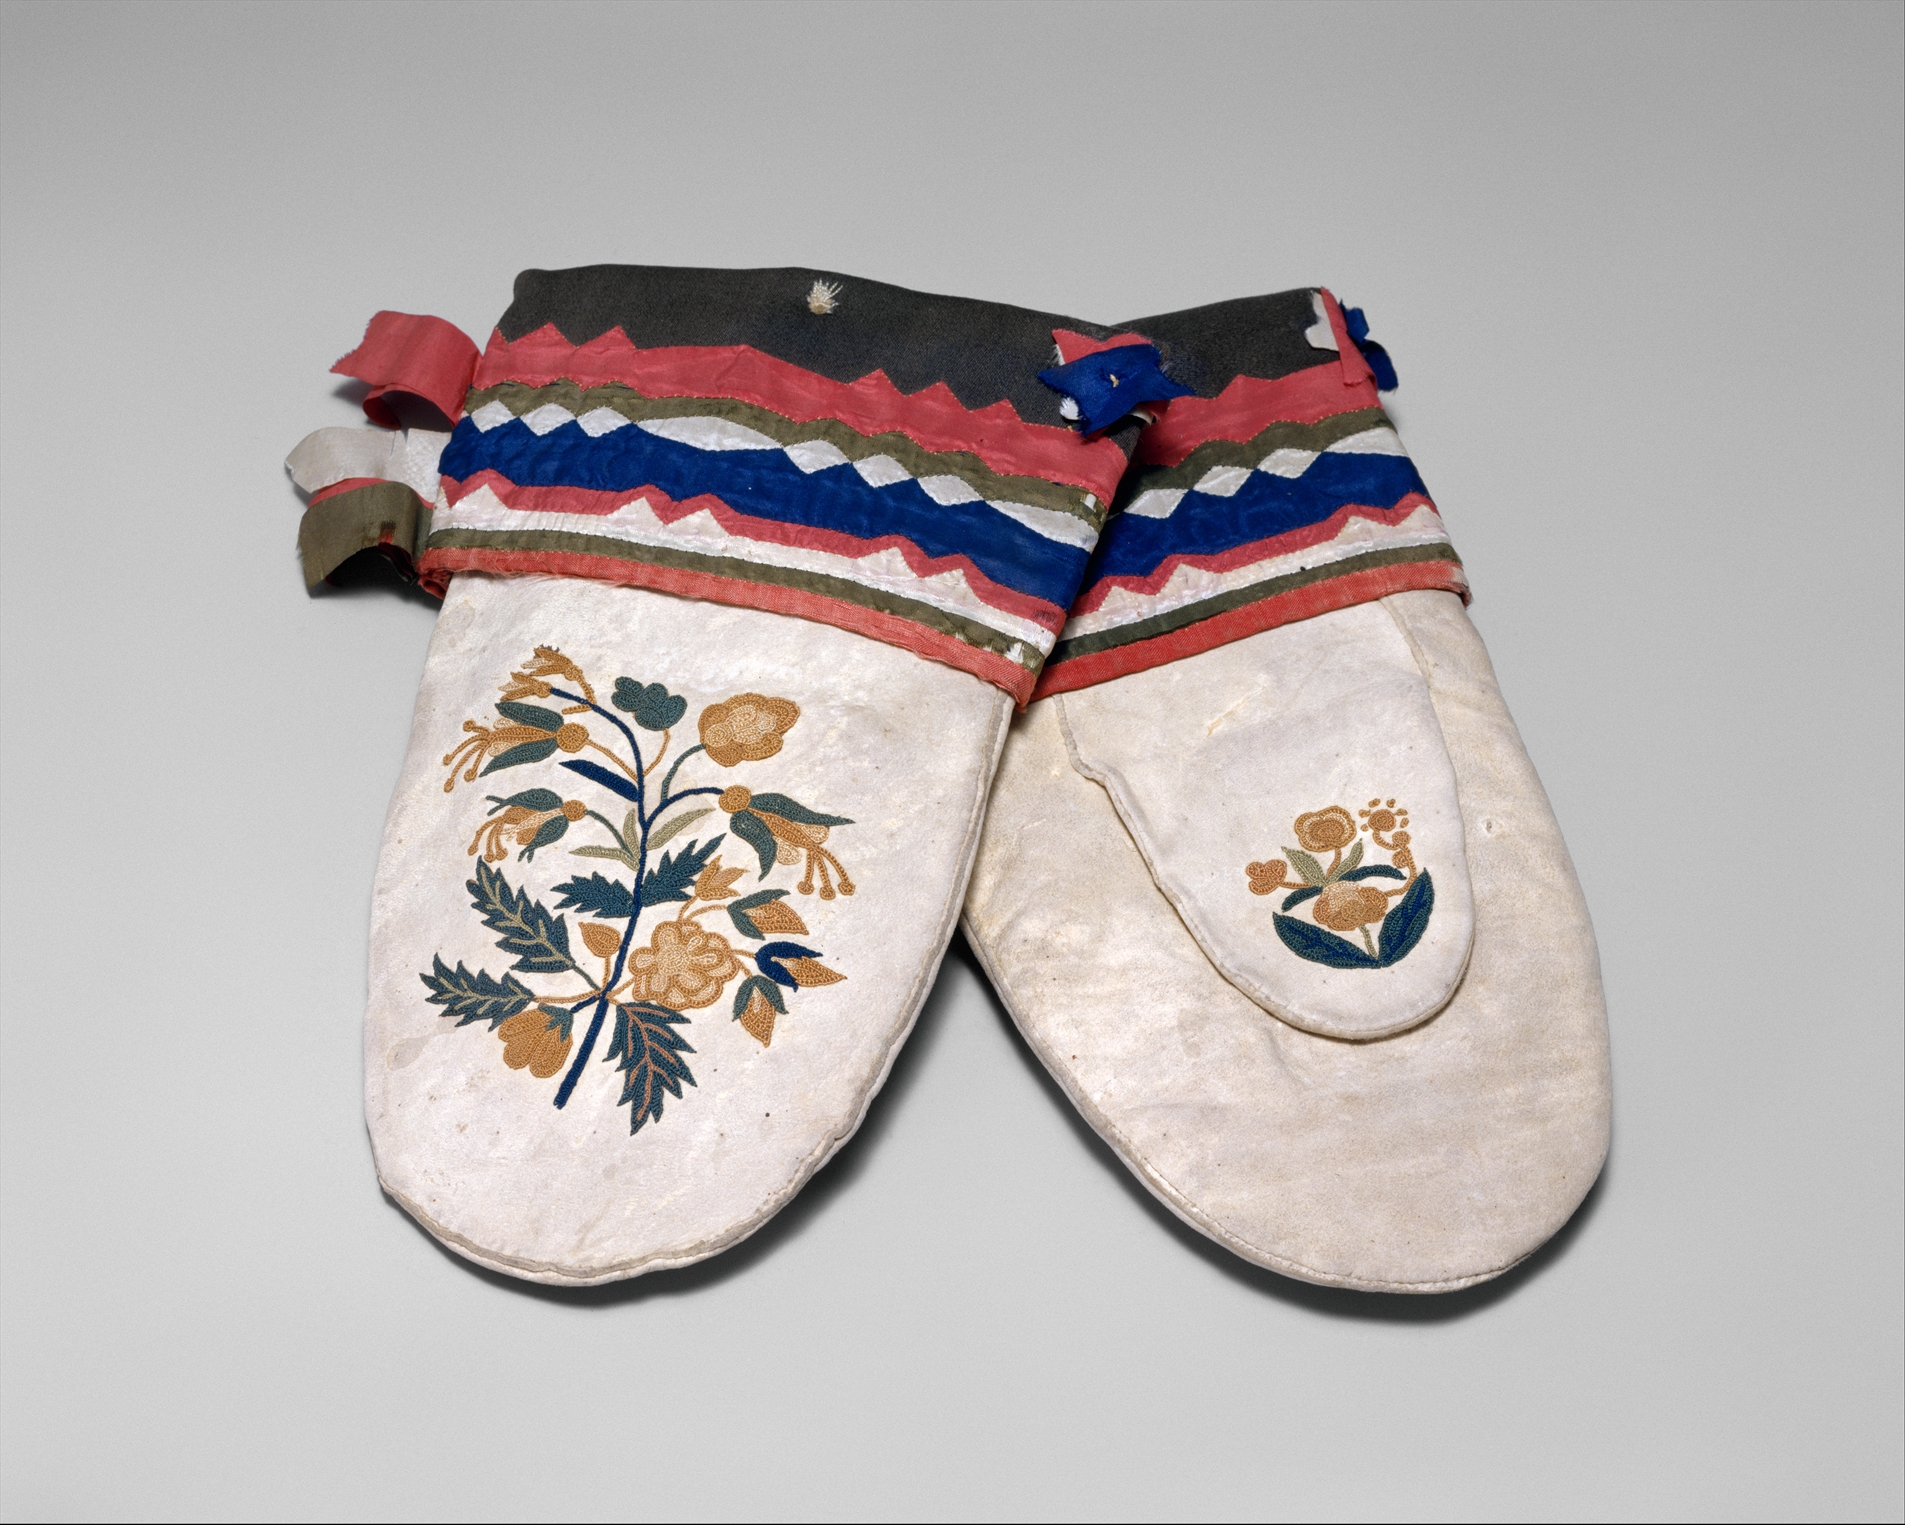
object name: mitten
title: Pair of Mittens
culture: cree or cree-métis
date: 1850-1860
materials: silk, skin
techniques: tanning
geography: canada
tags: flowers